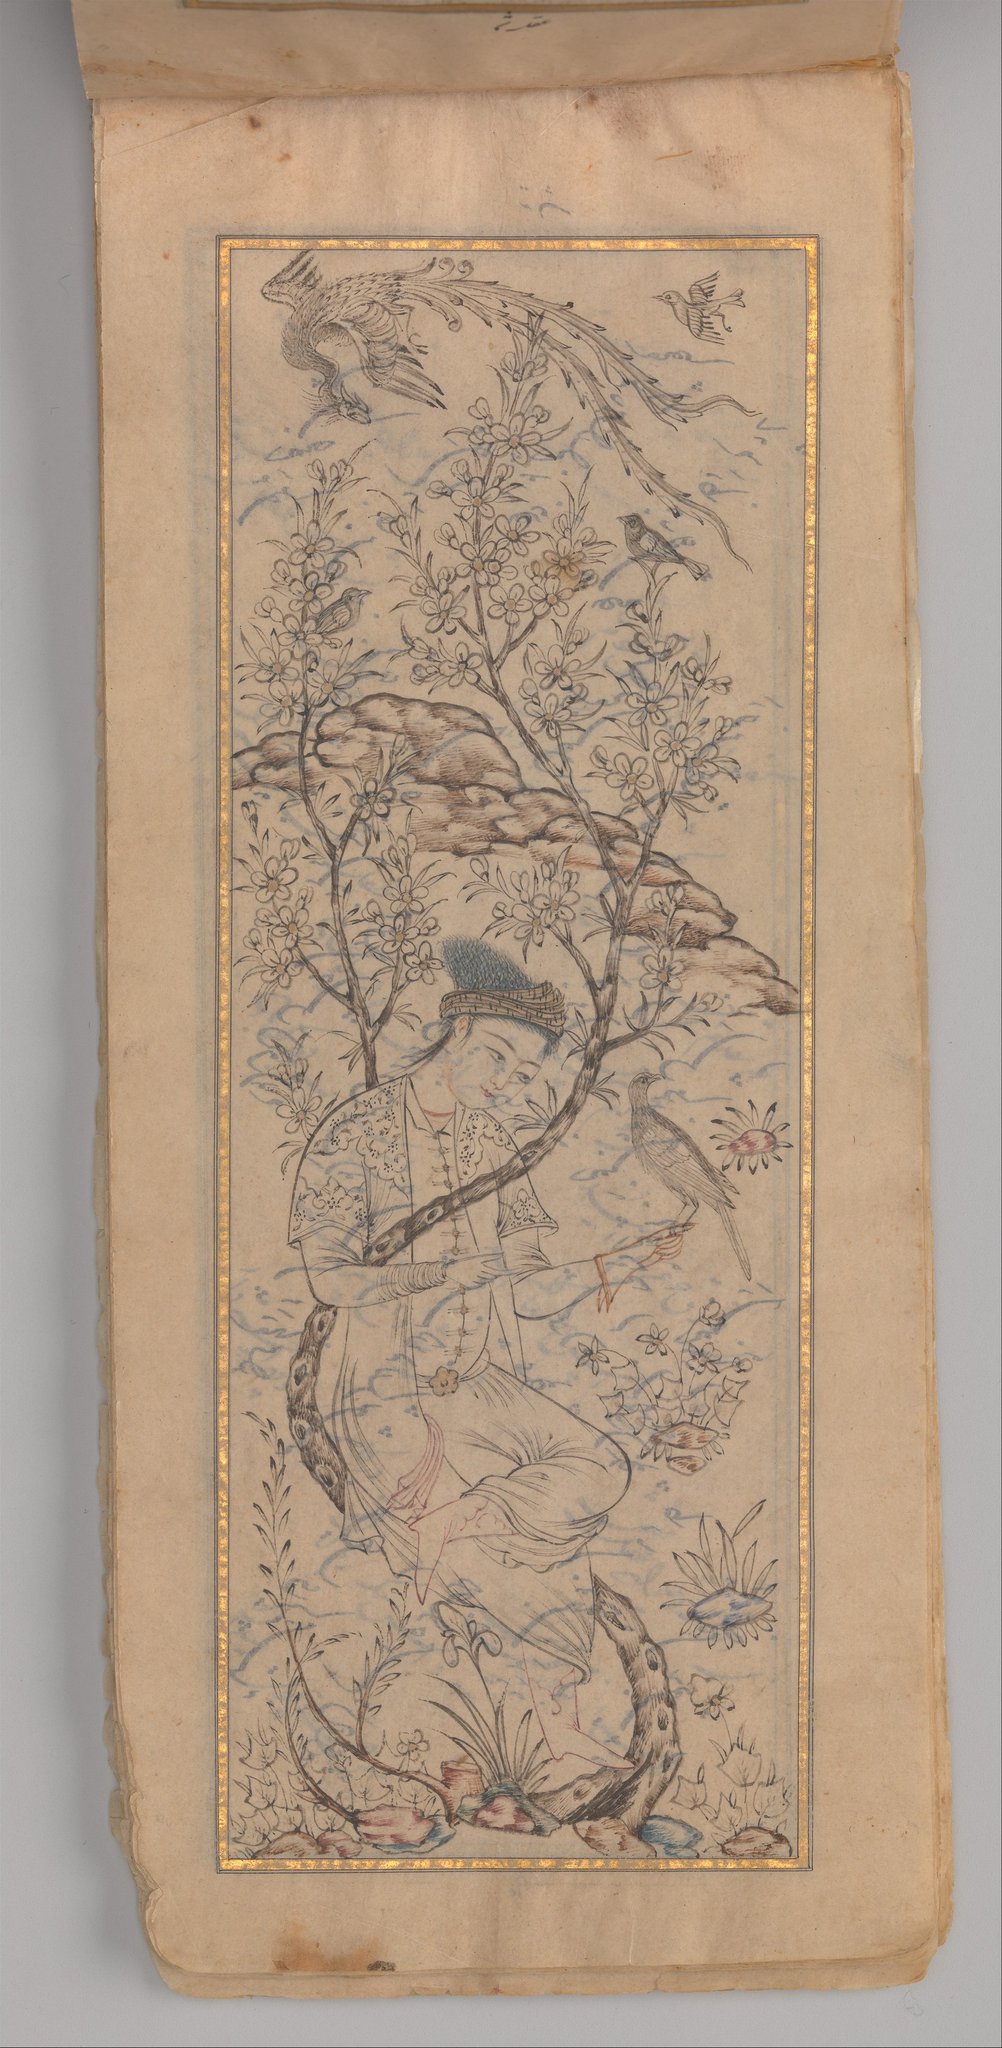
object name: illustrated manuscript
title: Anthology of Persian Poetry (Safina)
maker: 'abd al-'azim al-yahya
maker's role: calligrapher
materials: ink, leather, paper, watercolor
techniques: bookbinding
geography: iran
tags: birds,women,mythical creatures,flowers